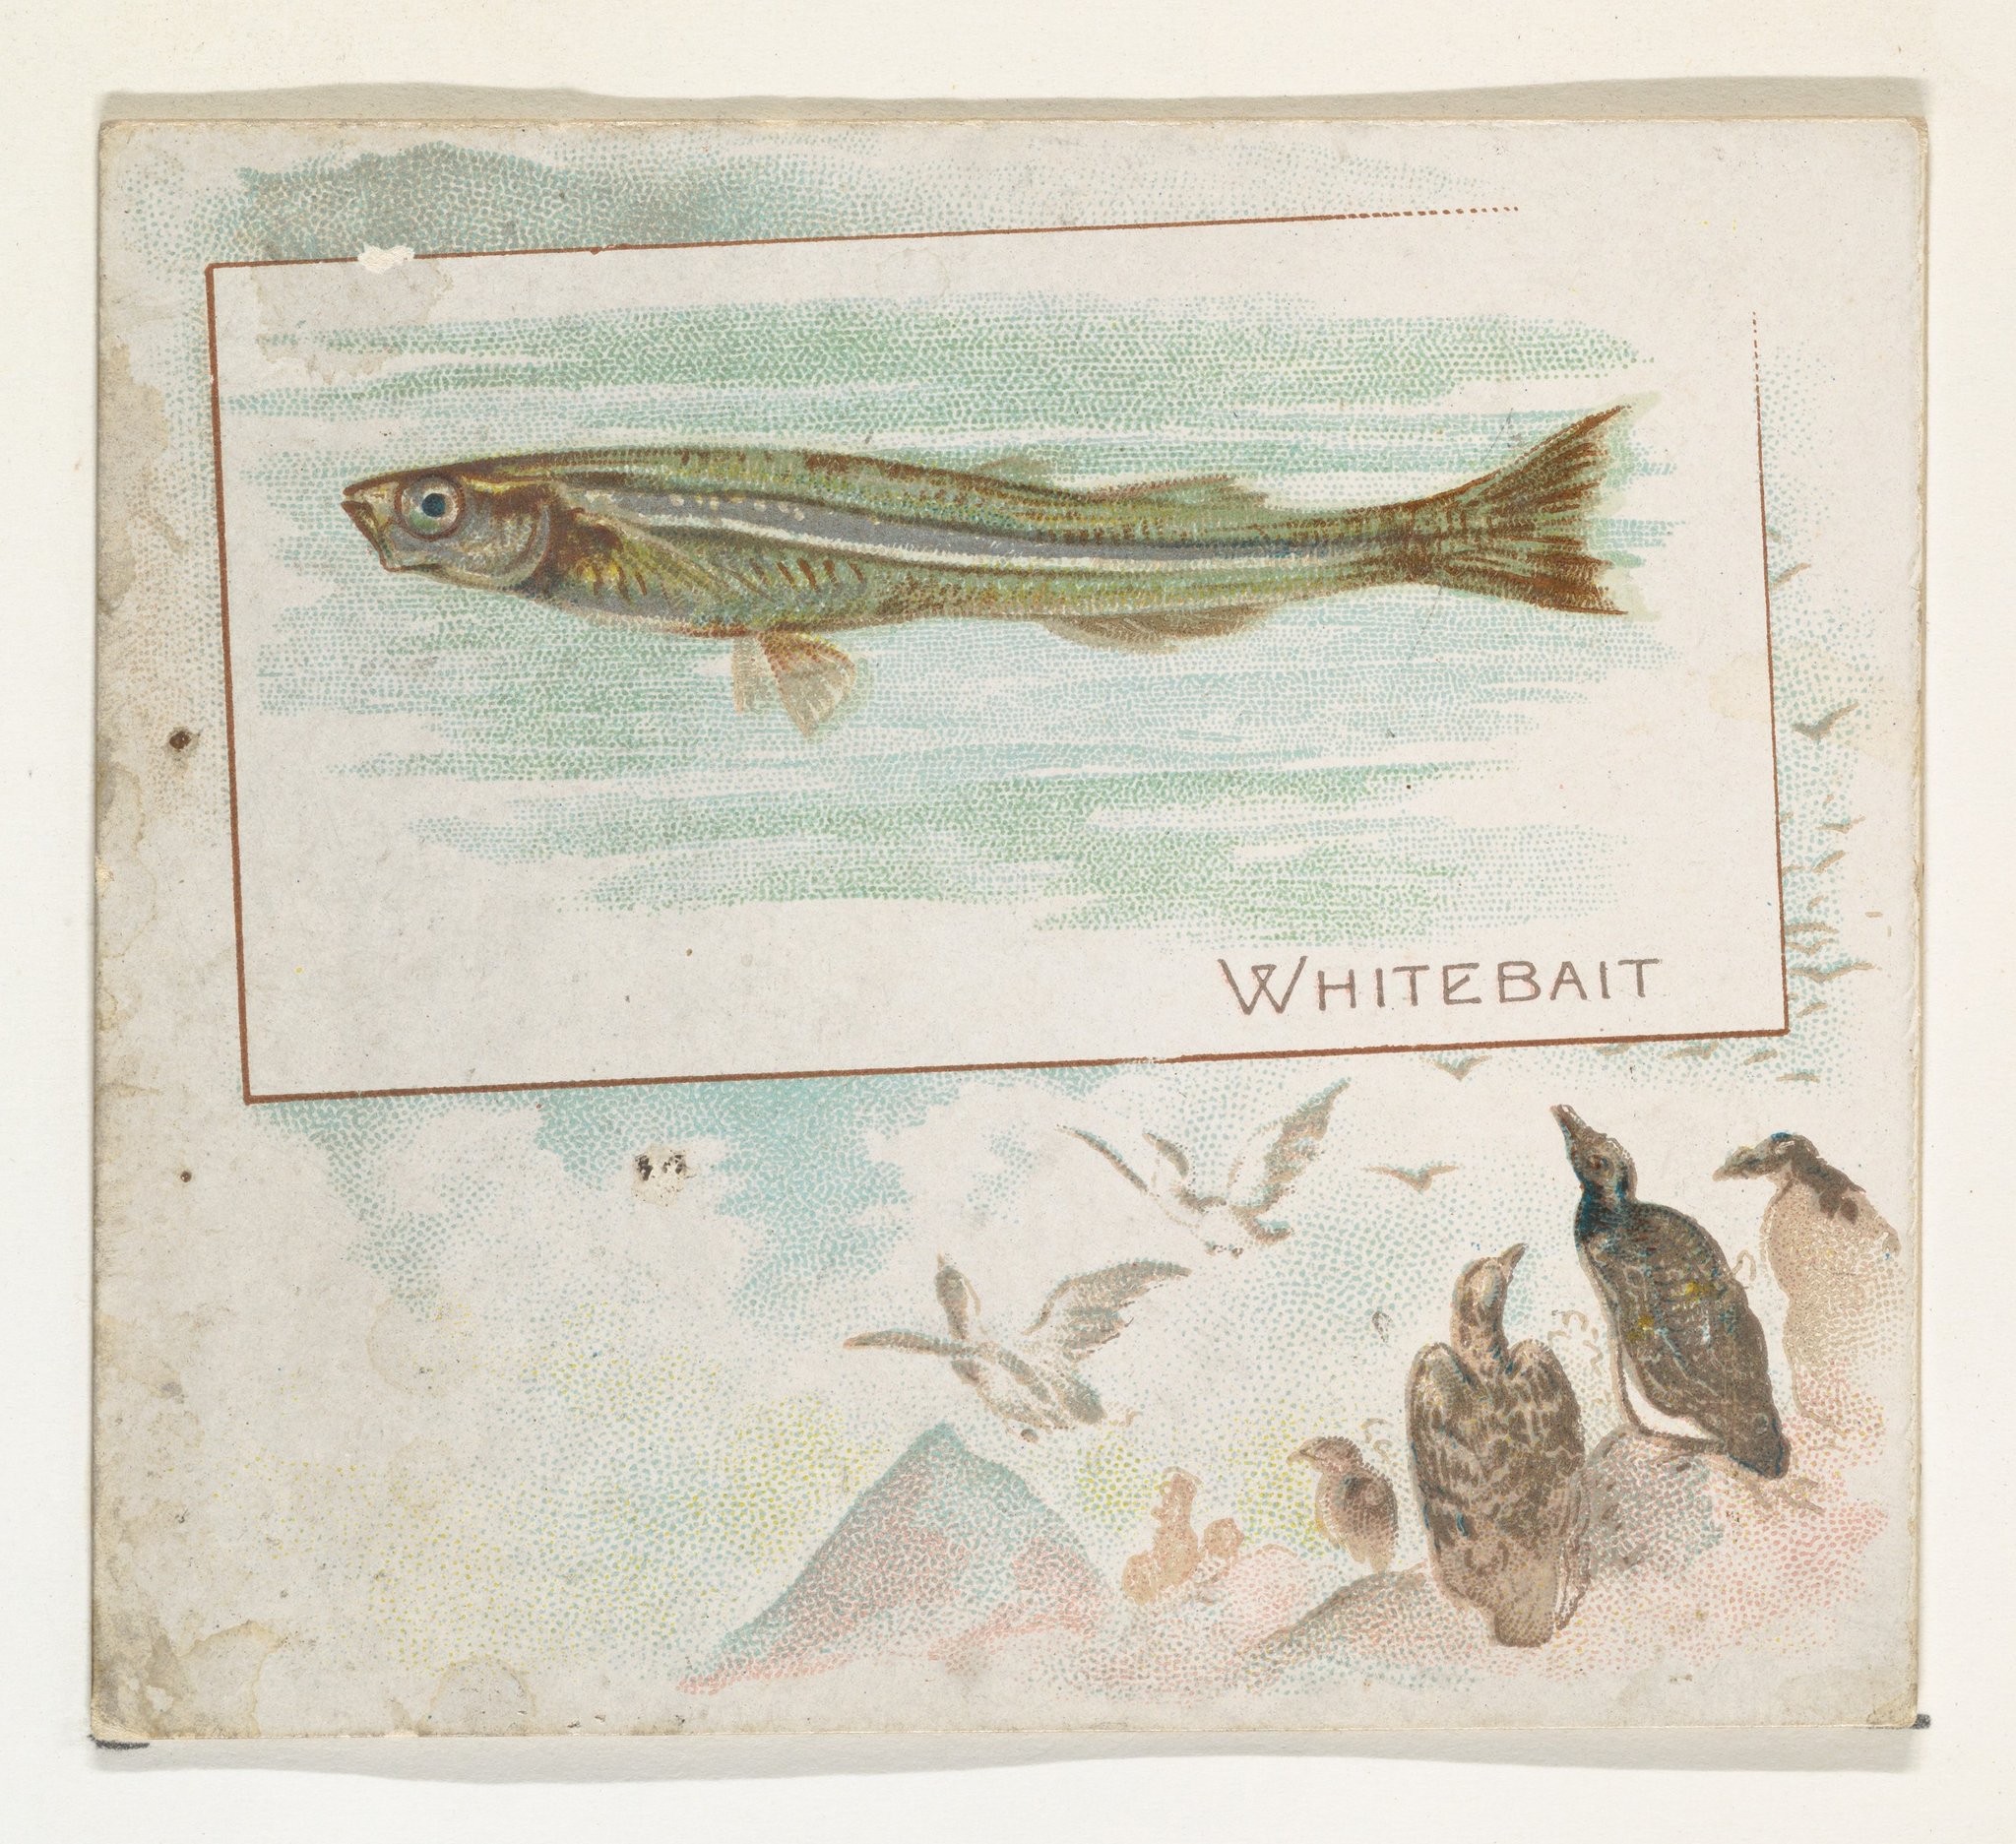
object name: print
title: Whitebait, from Fish from American Waters series (N39) for Allen & Ginter Cigarettes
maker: allen & ginter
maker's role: publisher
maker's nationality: american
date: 1889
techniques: color lithograph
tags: birds,fish